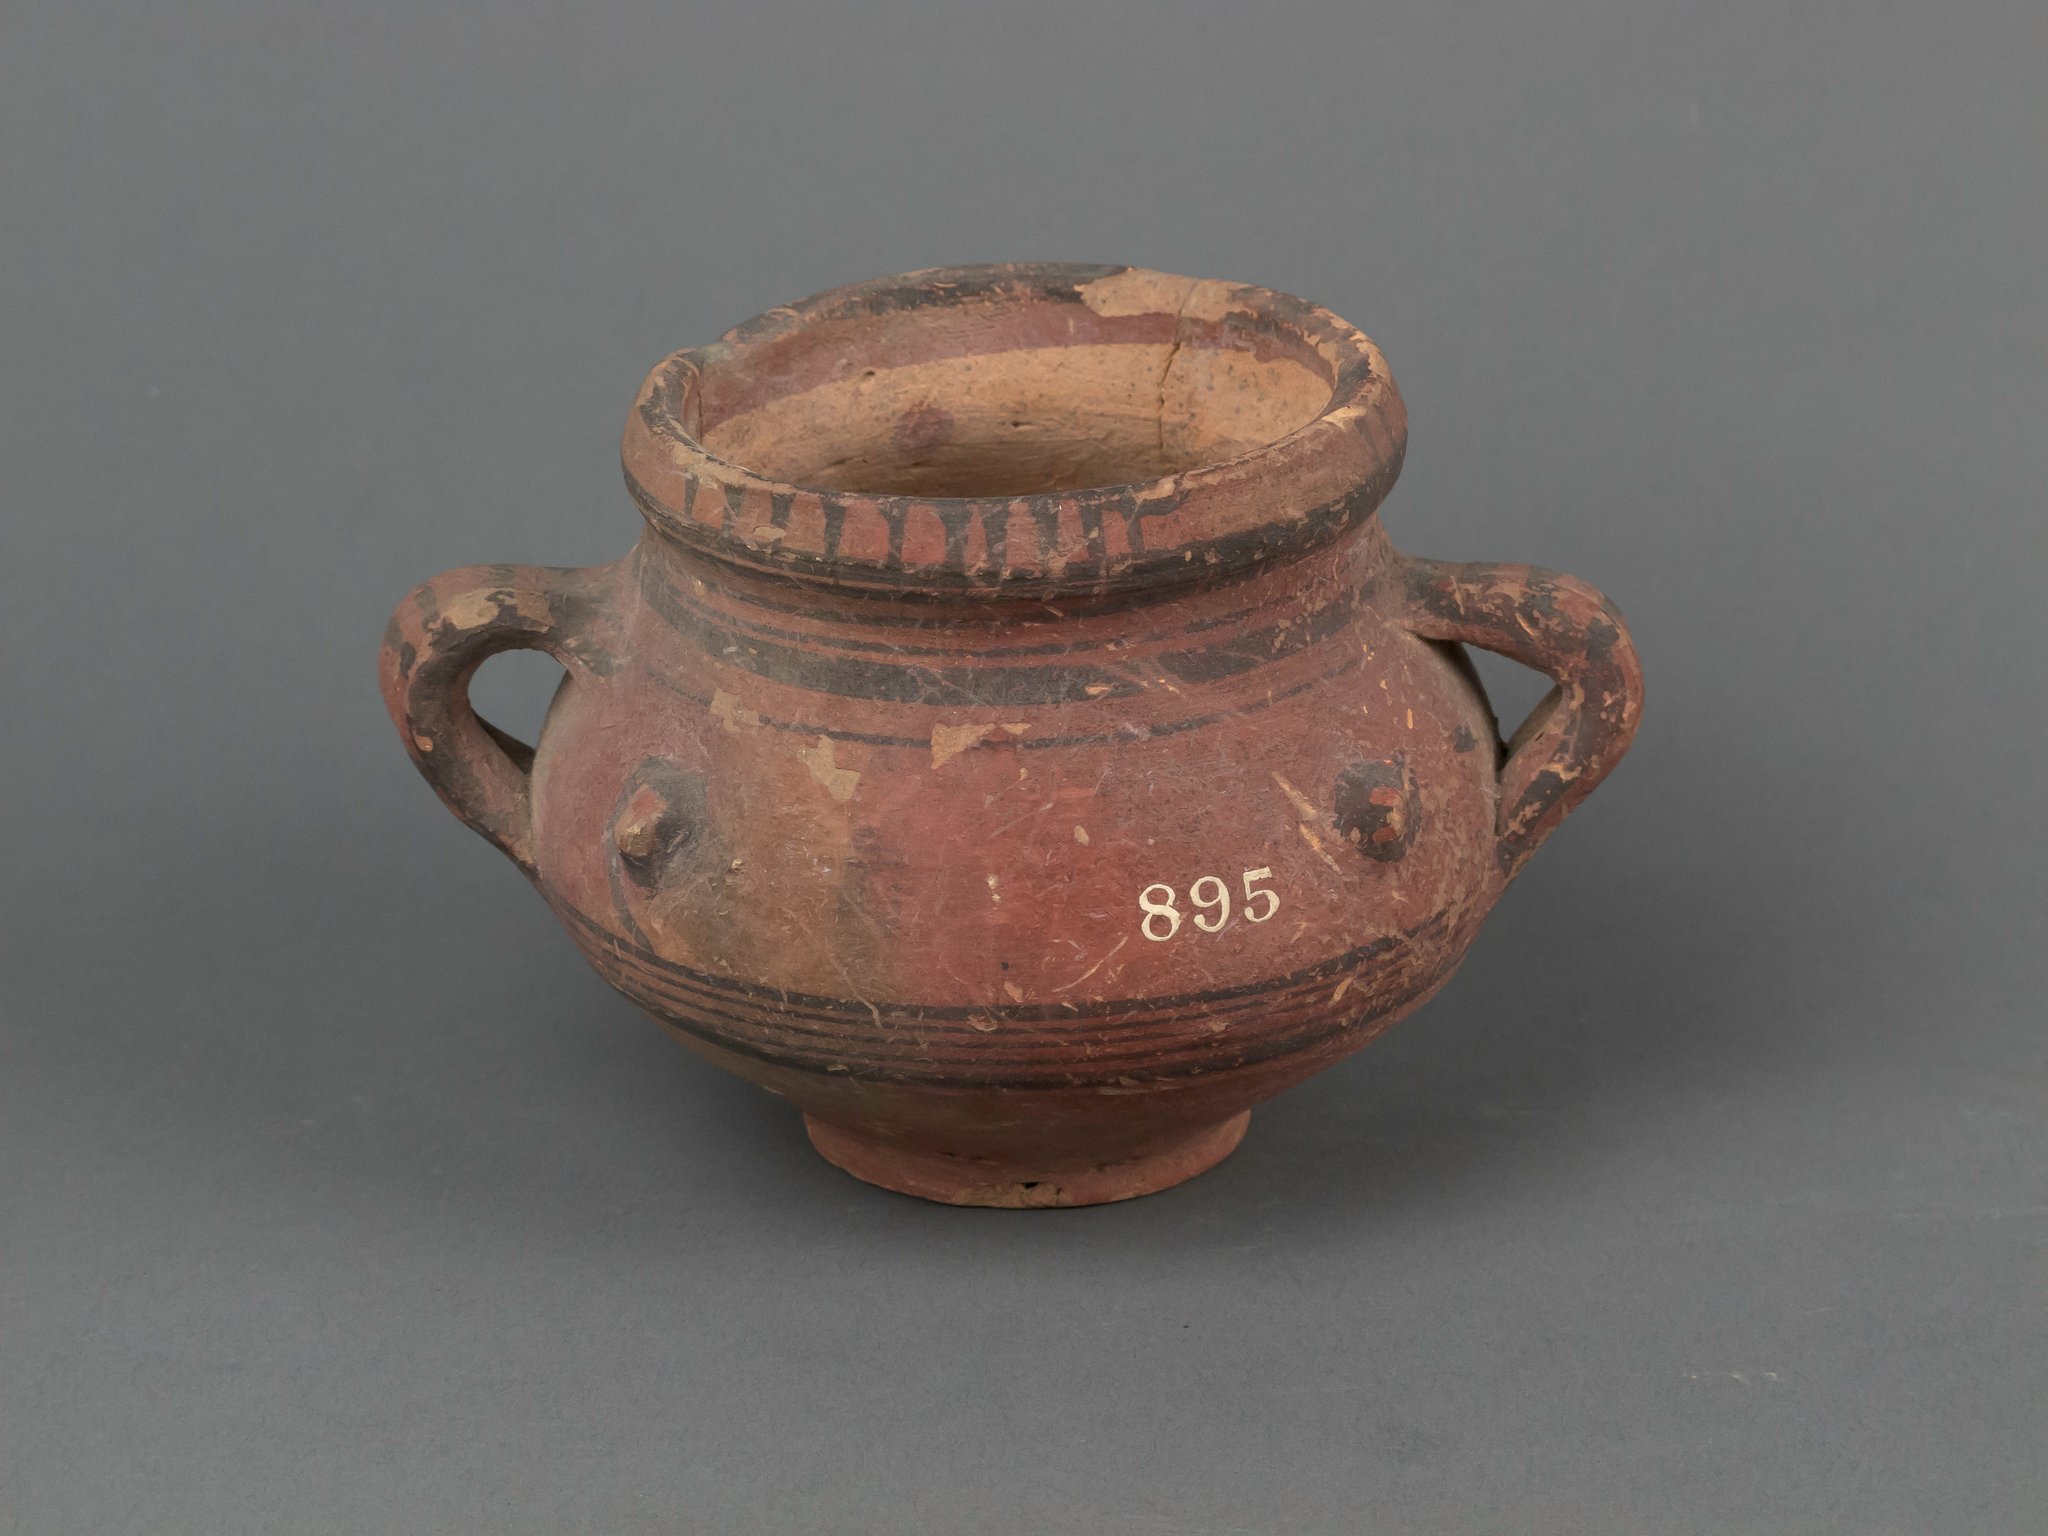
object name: amphoriskos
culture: cypriot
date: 600-480 BCE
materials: terracotta